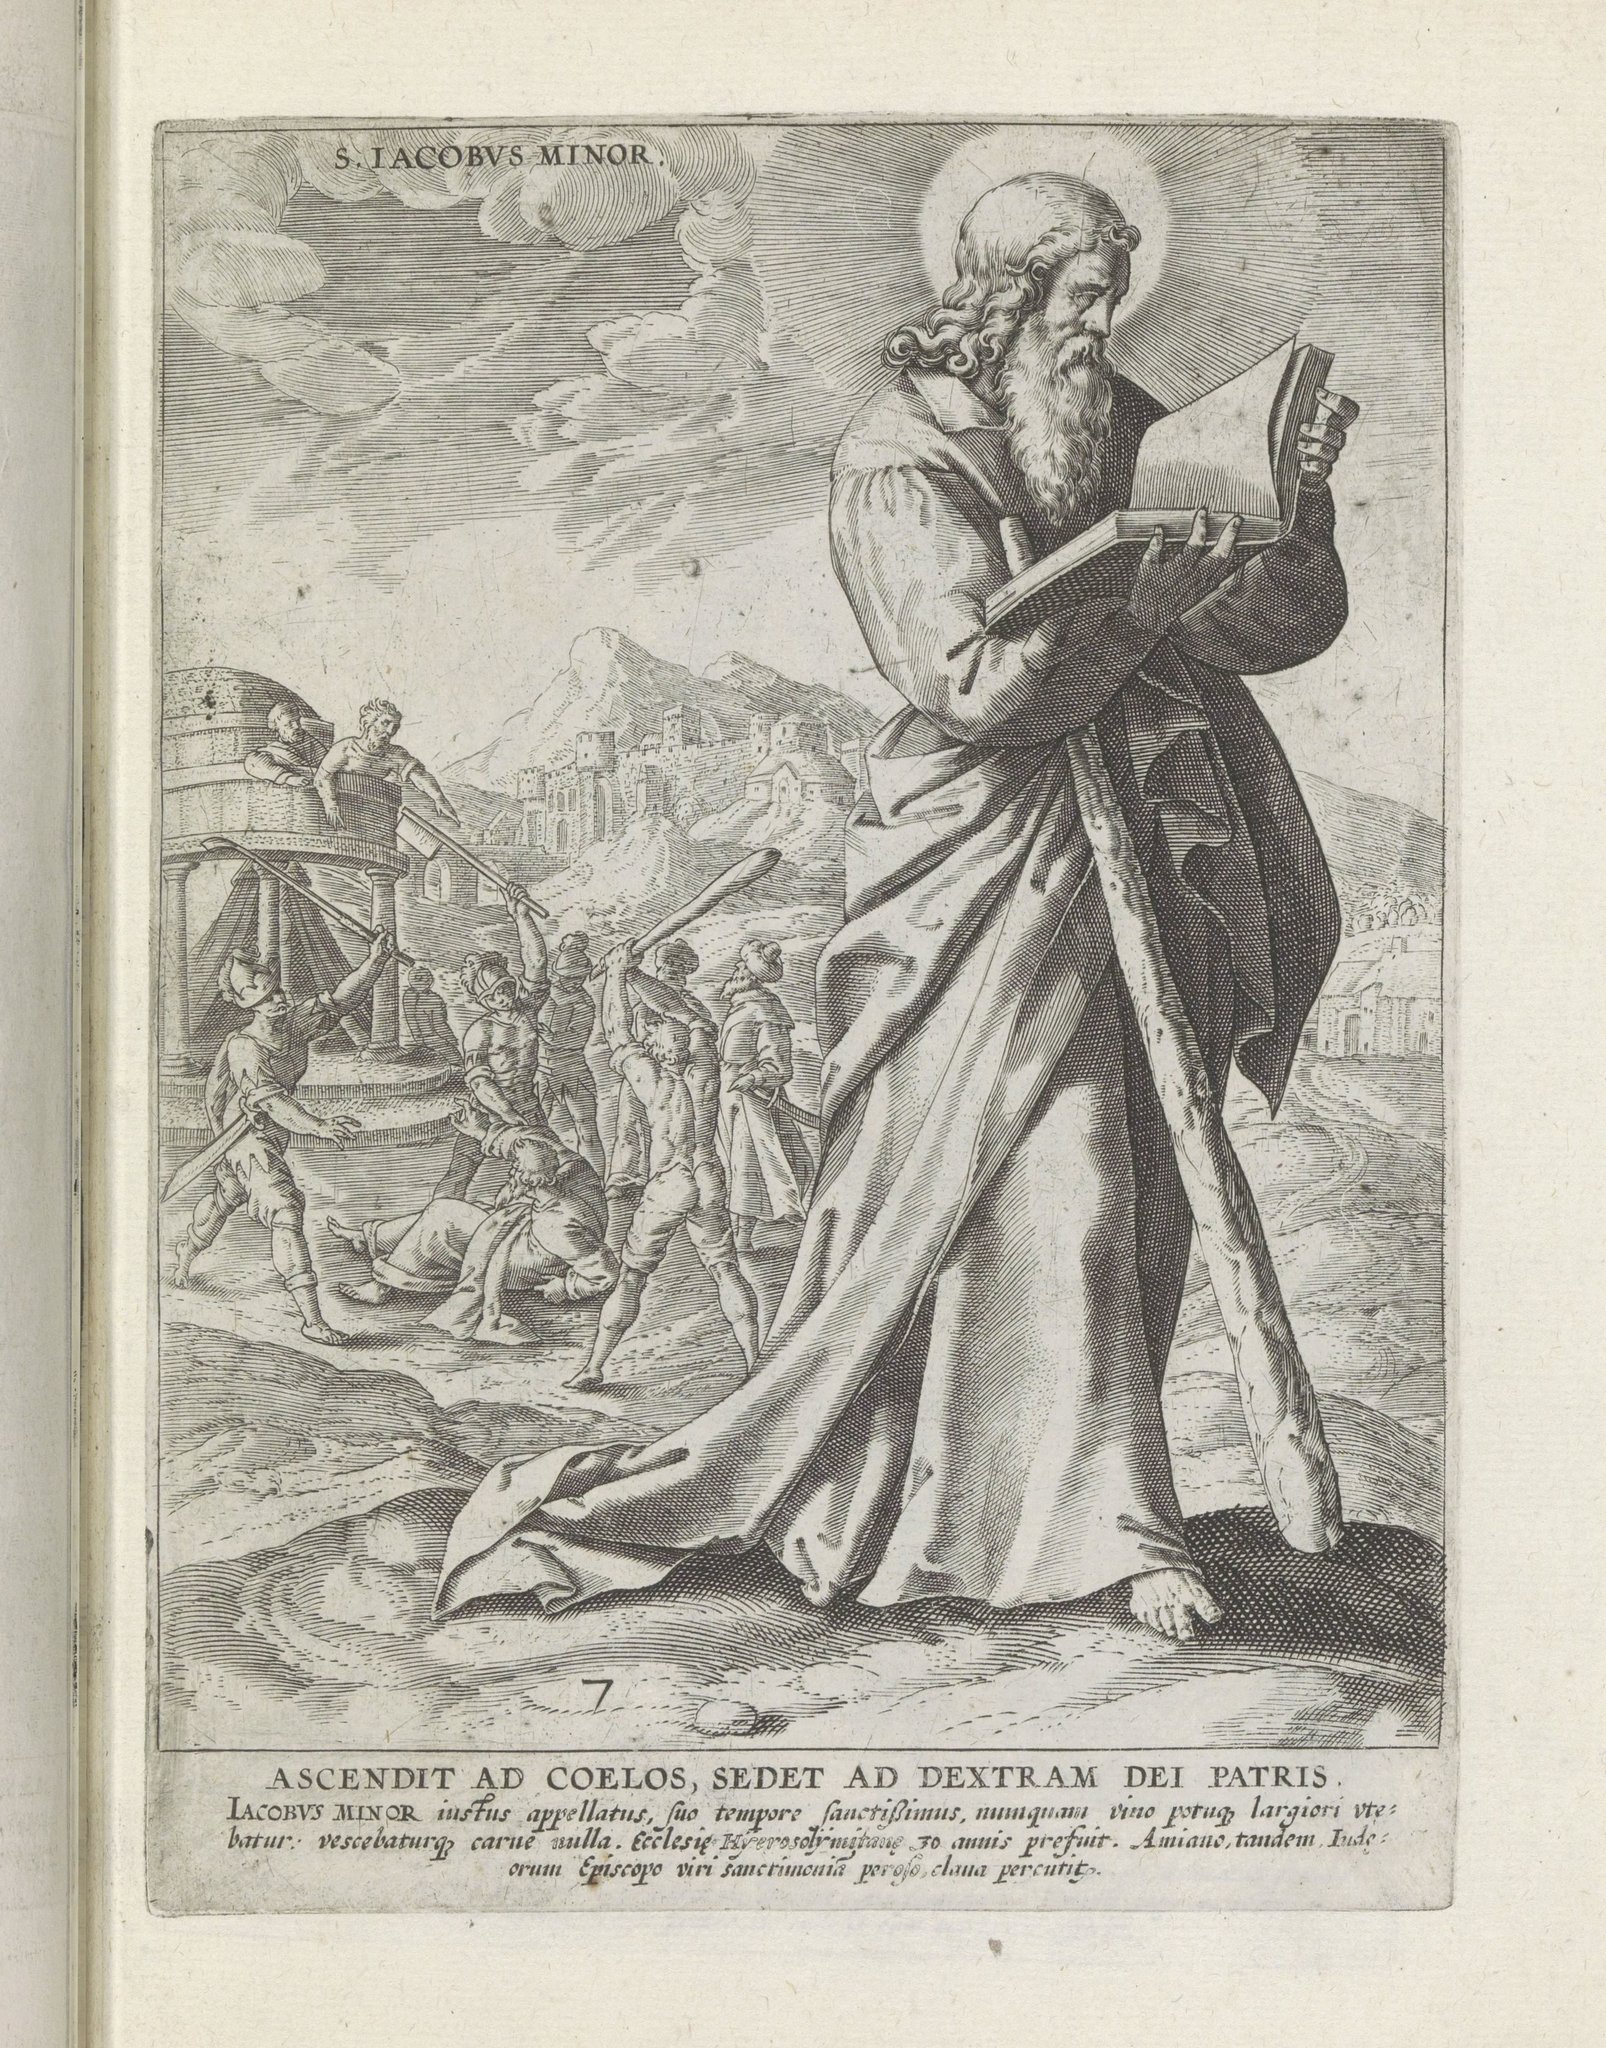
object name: album leaf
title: Thesaurus novi Testamenti elegantissimis iconibus expressus continens historias atque miracula doni nostri Iesu Christi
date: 1585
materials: paper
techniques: engraving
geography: antwerp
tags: the apostle james the less, first bishop of jerusalem; possible attributes: book, fuller's club, scroll, the apostle james the less, first bishop of jerusalem; possible attributes: book, fuller's club, scroll - martyrdom, suffering, misfortune, death of male saint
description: De apostel Jakobus de Mindere staande met de voldersknuppel tegen zich aangeklemt en een boek in de handen. Links op de achtergrond zijn marteldood. Hij wordt doodgeslagen. Onder de voorstelling een regel uit de apostolische geloofsbelijdenis en een drieregelige tekst over Jakobus de Mindere in het Latijn. Deze prent maakt deel uit van een album.